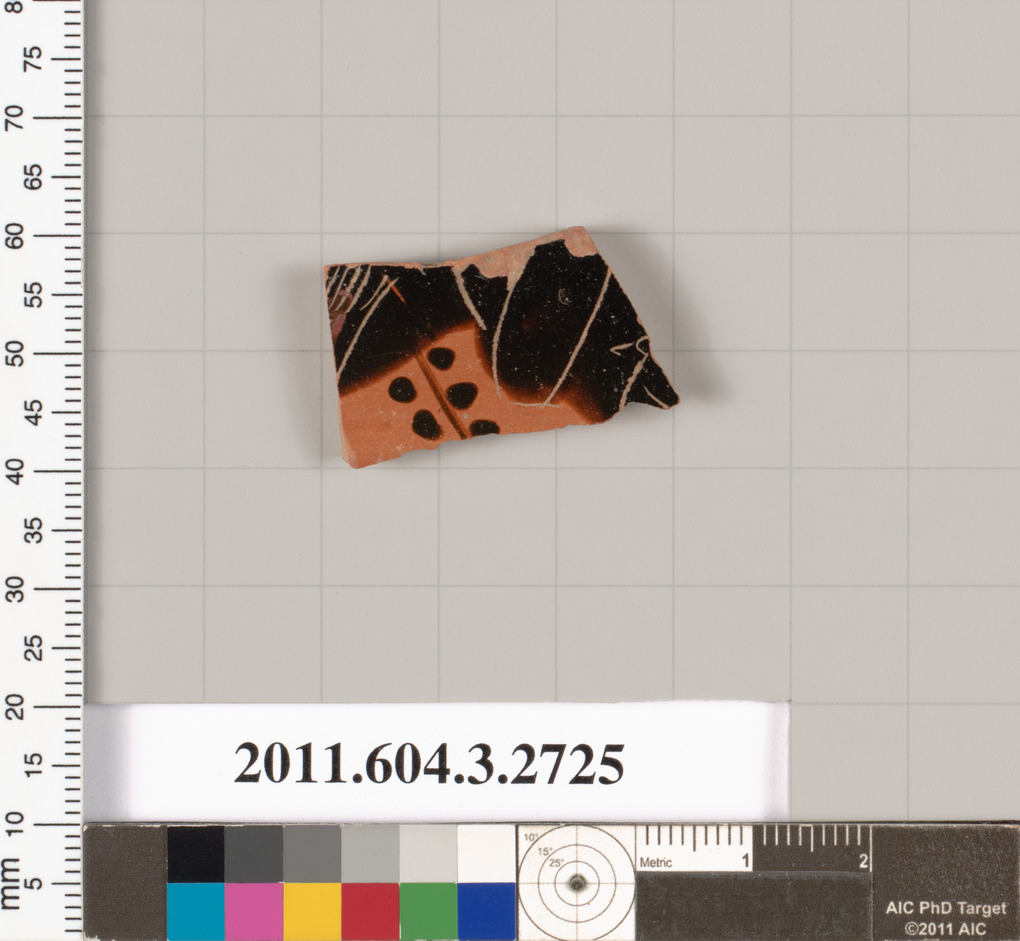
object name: oinochoe fragment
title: Terracotta fragment of an oinochoe (jug)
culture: greek, attic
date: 534-468 BCE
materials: terracotta